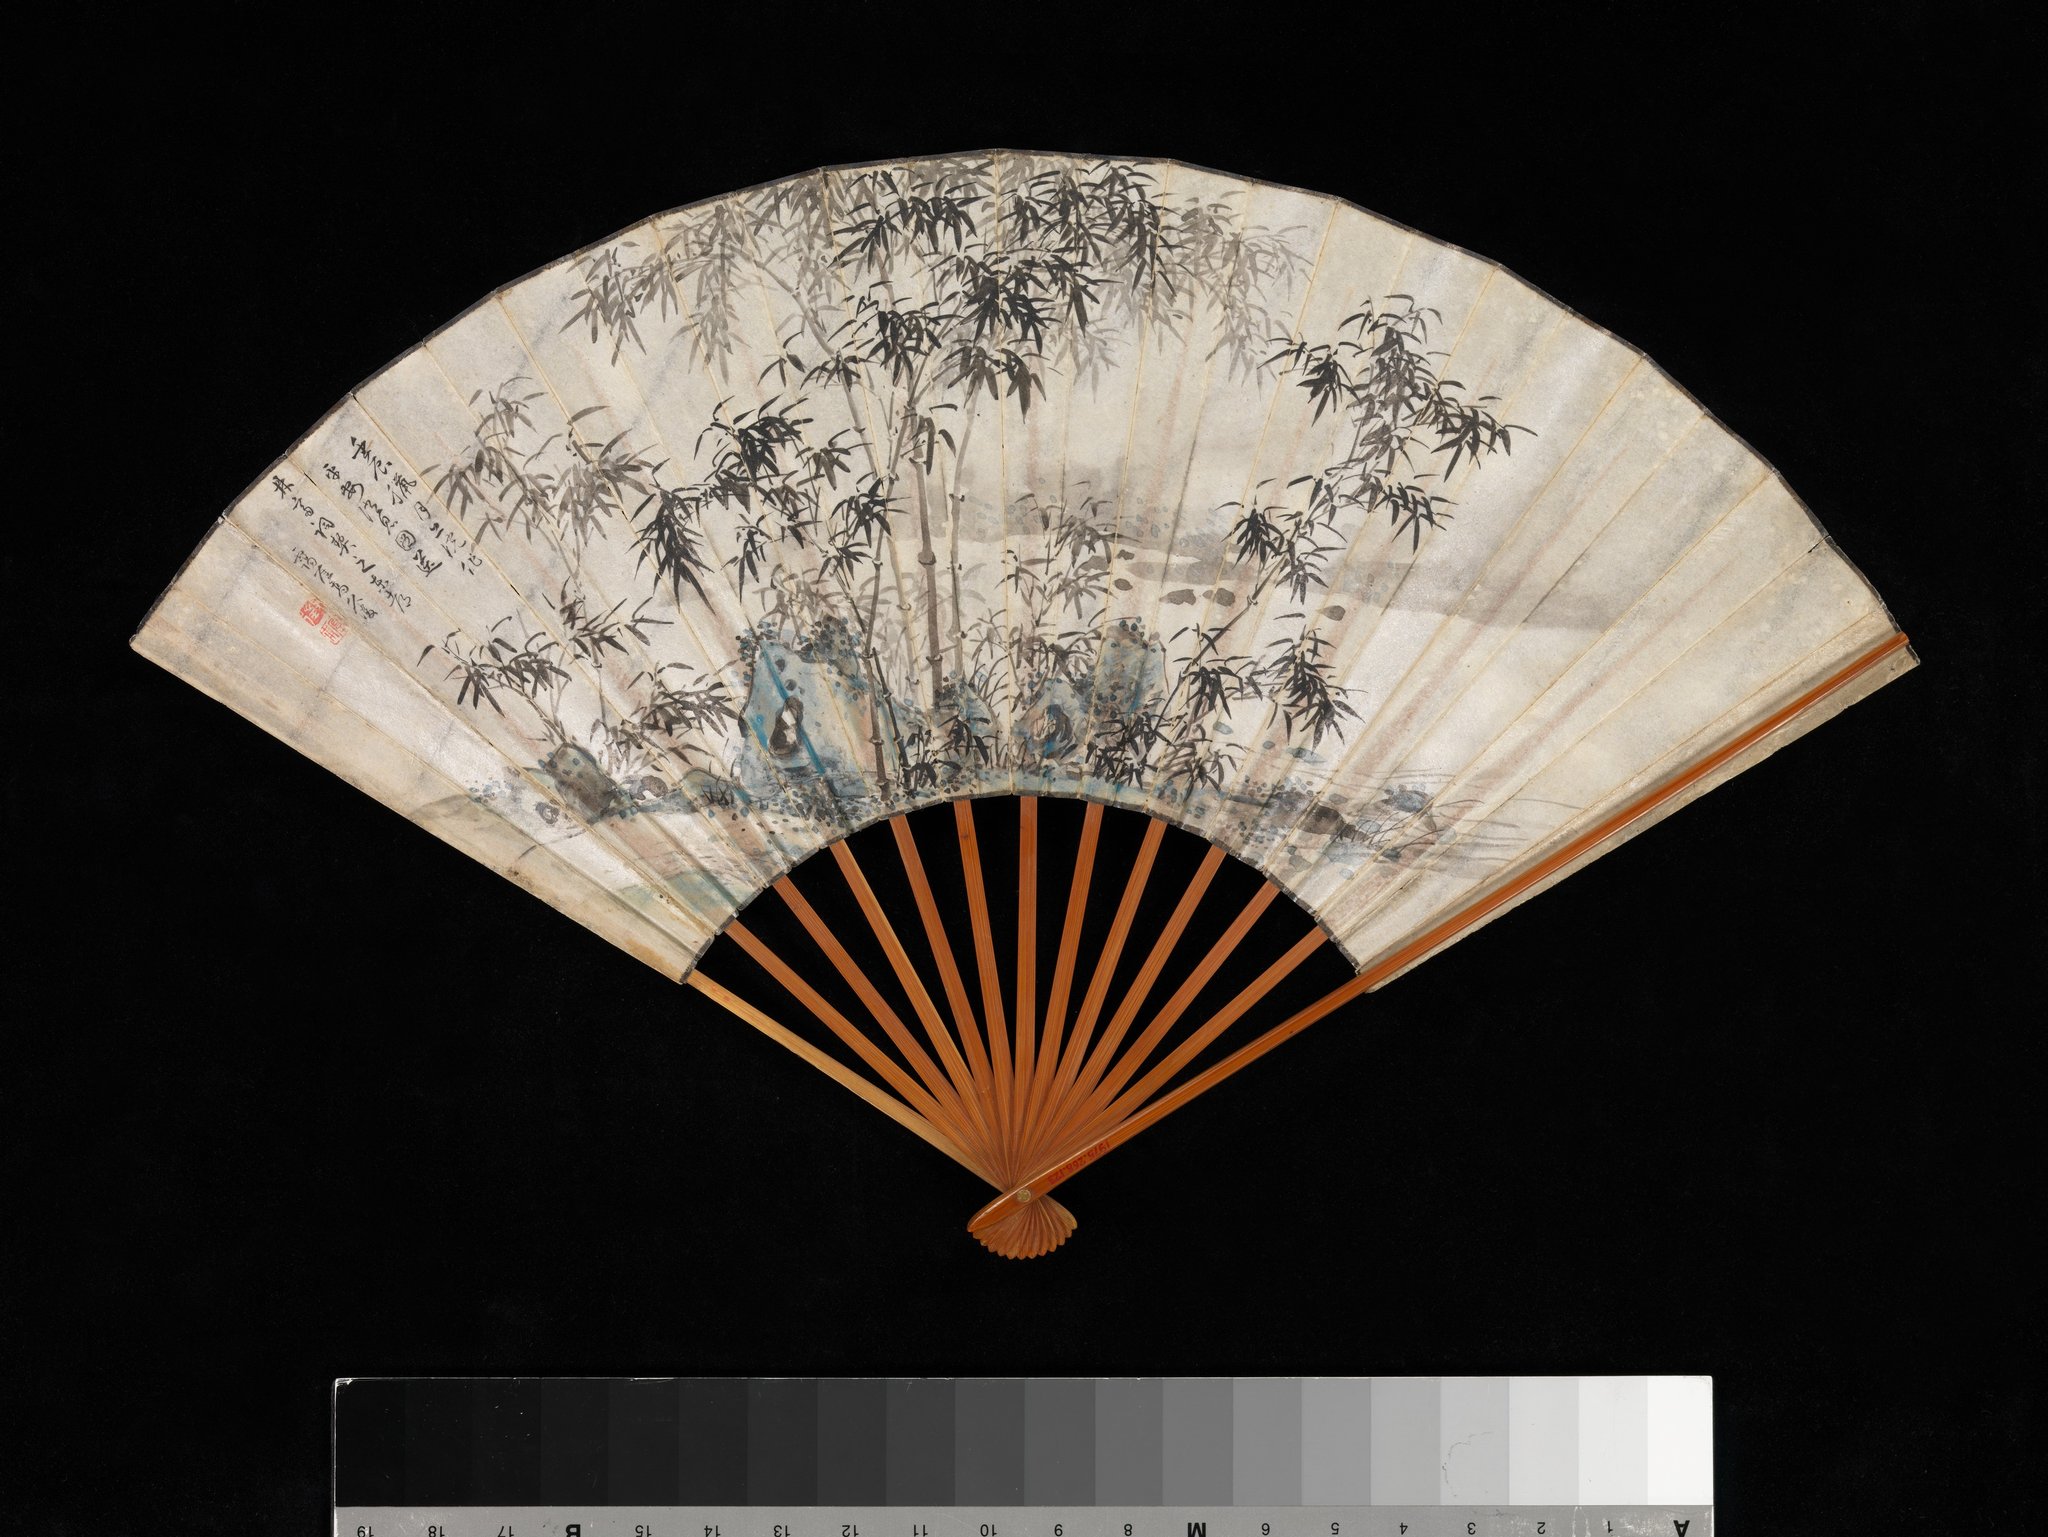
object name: folding fan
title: Bamboo and Rocks by a Stream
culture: japanese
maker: takaku aigai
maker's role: artist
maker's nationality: japanese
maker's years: 1796-1843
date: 1832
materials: ink, paper, wood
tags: bamboo